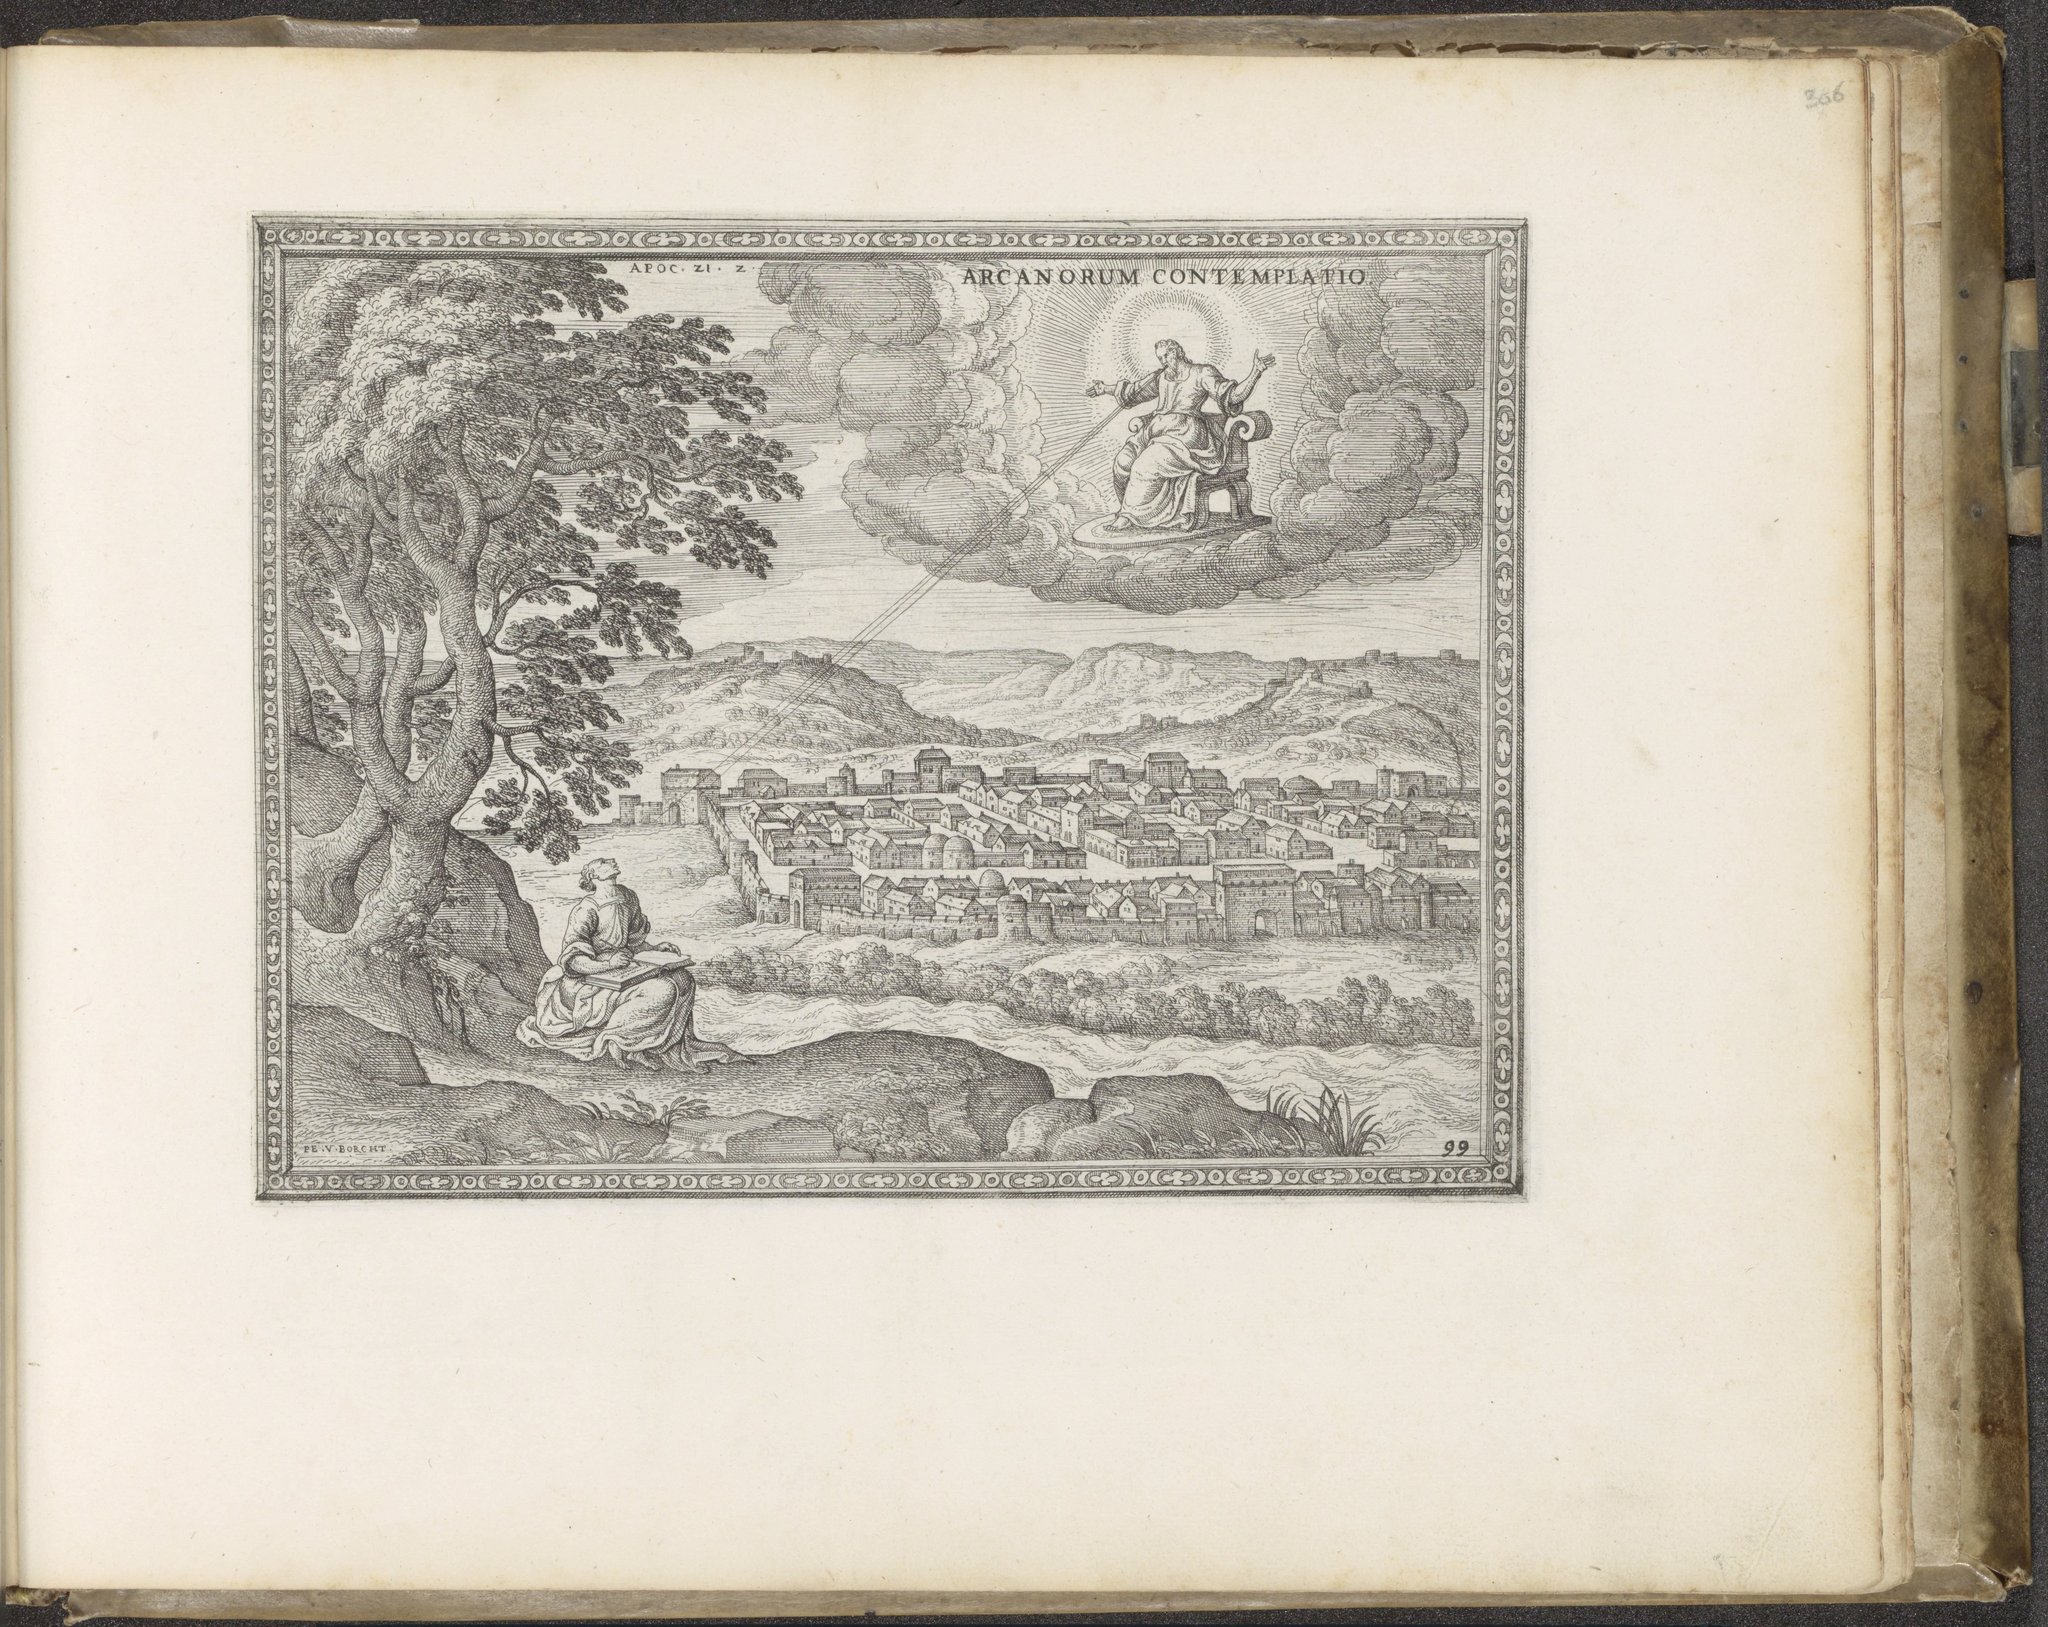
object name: album leaf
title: Arcanorum contemplatio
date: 1582-1593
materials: paper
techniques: etching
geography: amsterdam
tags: the new jerusalem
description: Johannes de Evangelist schrijft op Patmos aan zijn Openbaring. God de Vader op zijn troon tussen de wolken geeft hem een visioen over het nieuwe Jeruzalem (Apoc. 21). De prent maakt deel uit van een album.